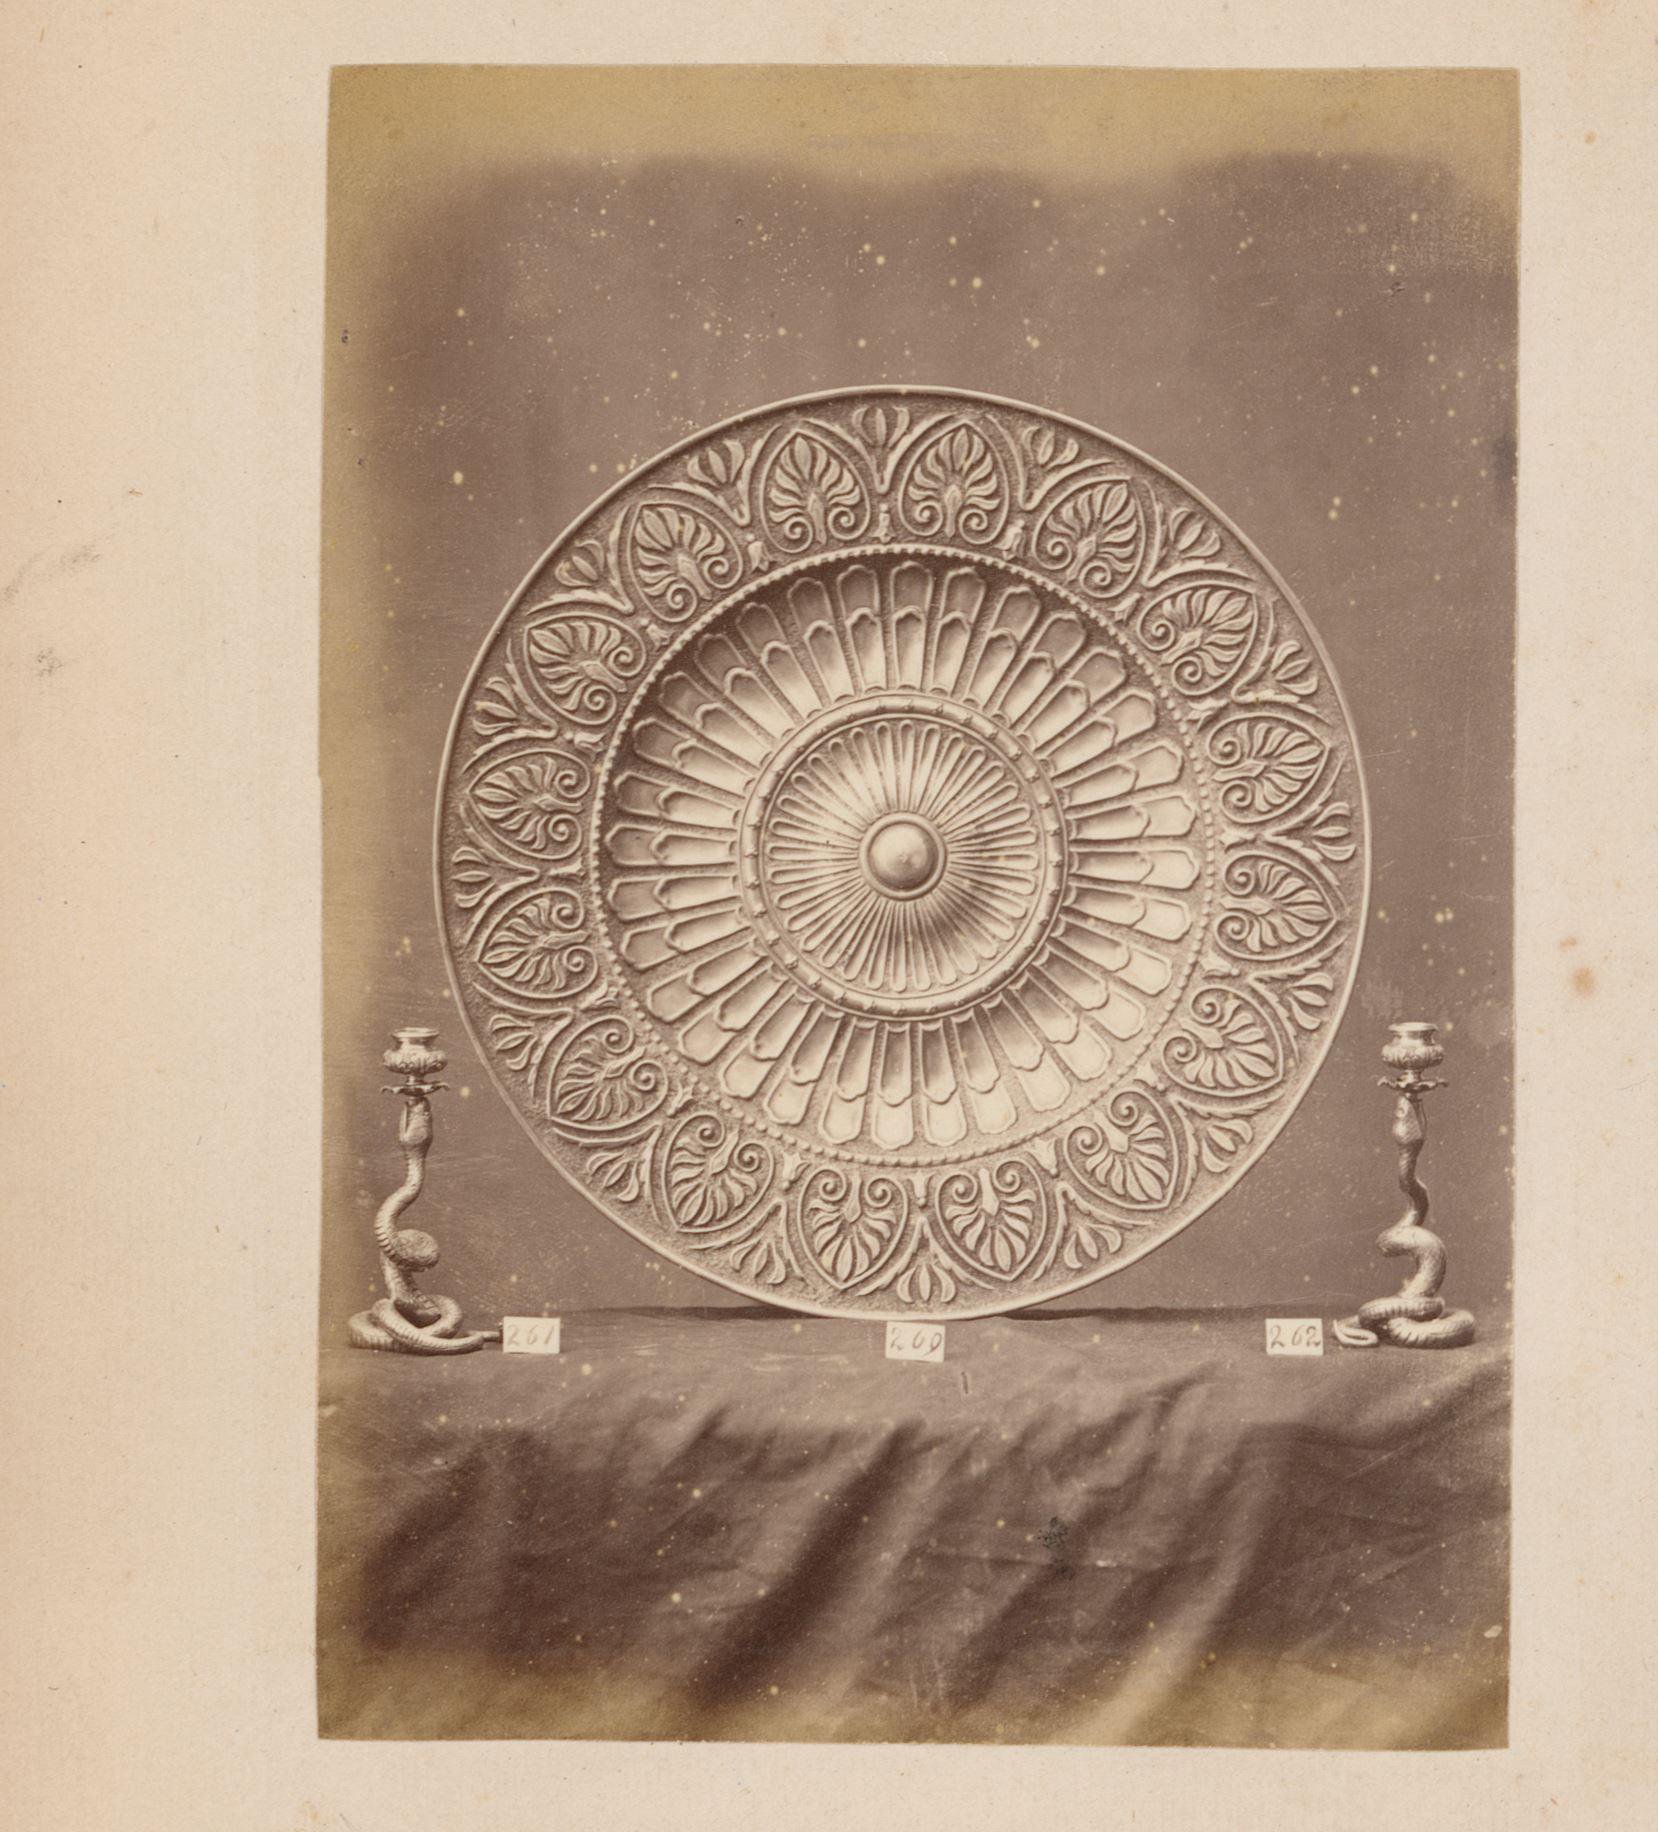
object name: page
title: Metalen bord en twee kandelaars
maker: Anonymous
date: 1860-1885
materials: photographic support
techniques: albumen print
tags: dish, plate, saucer, candlestick